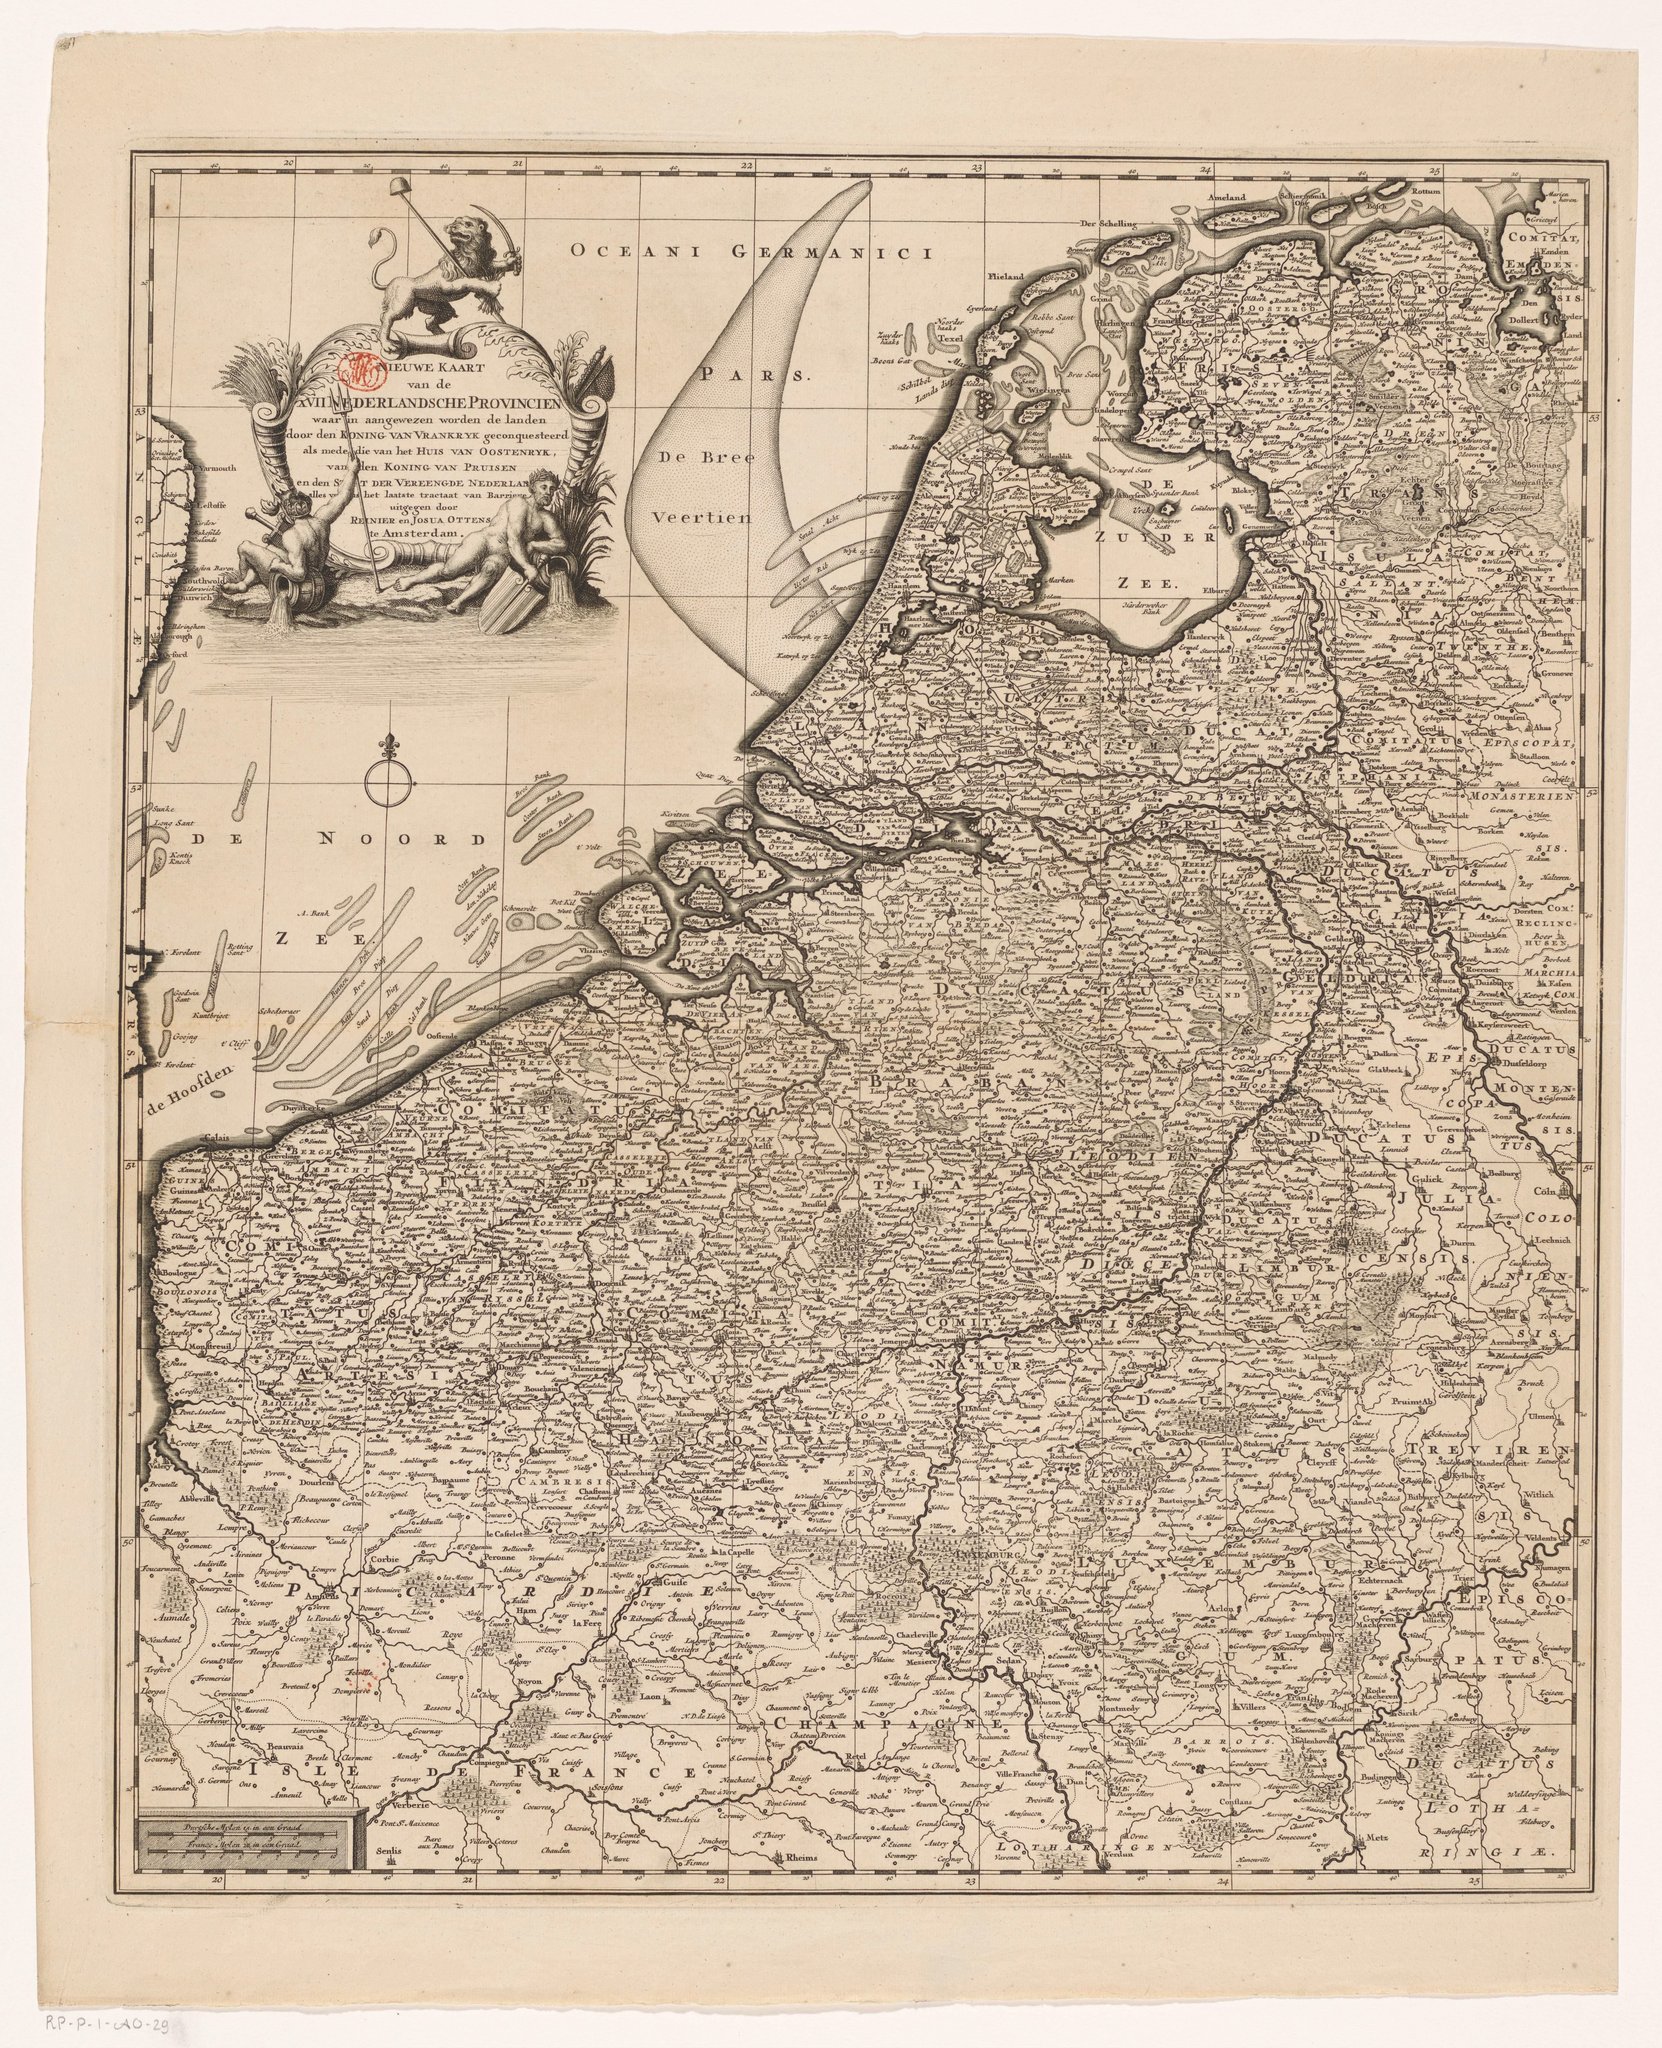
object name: map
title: Kaart van de Zeventien Provinciën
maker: joachim ottens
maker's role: print maker, publisher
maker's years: 1663-1719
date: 1715-1737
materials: paper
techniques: engraving, etching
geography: amsterdam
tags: maps of separate countries or regions, river-gods, netherlands, belgium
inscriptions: collector's mark: Lugt 195, collector's mark: Lugt 2228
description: Op de kaart is een demarcatielijn ingetekend die aangeeft welke gebieden de Republiek na het Barrièretractaat van 1715 moest afstaan aan Frankrijk, Oostenrijk en Pruisen. Linksboven cartouche, daarboven Nederlandse Leeuw met vrijheidshoed en pijlenbundel en onder twee riviergoden. Linksonder schaalstok: Duytsche mylen 23 in een graad en France mylen 20 in een graad. De prent is voorzien van een coördinaten-net en een gradenverdeling langs de randen.